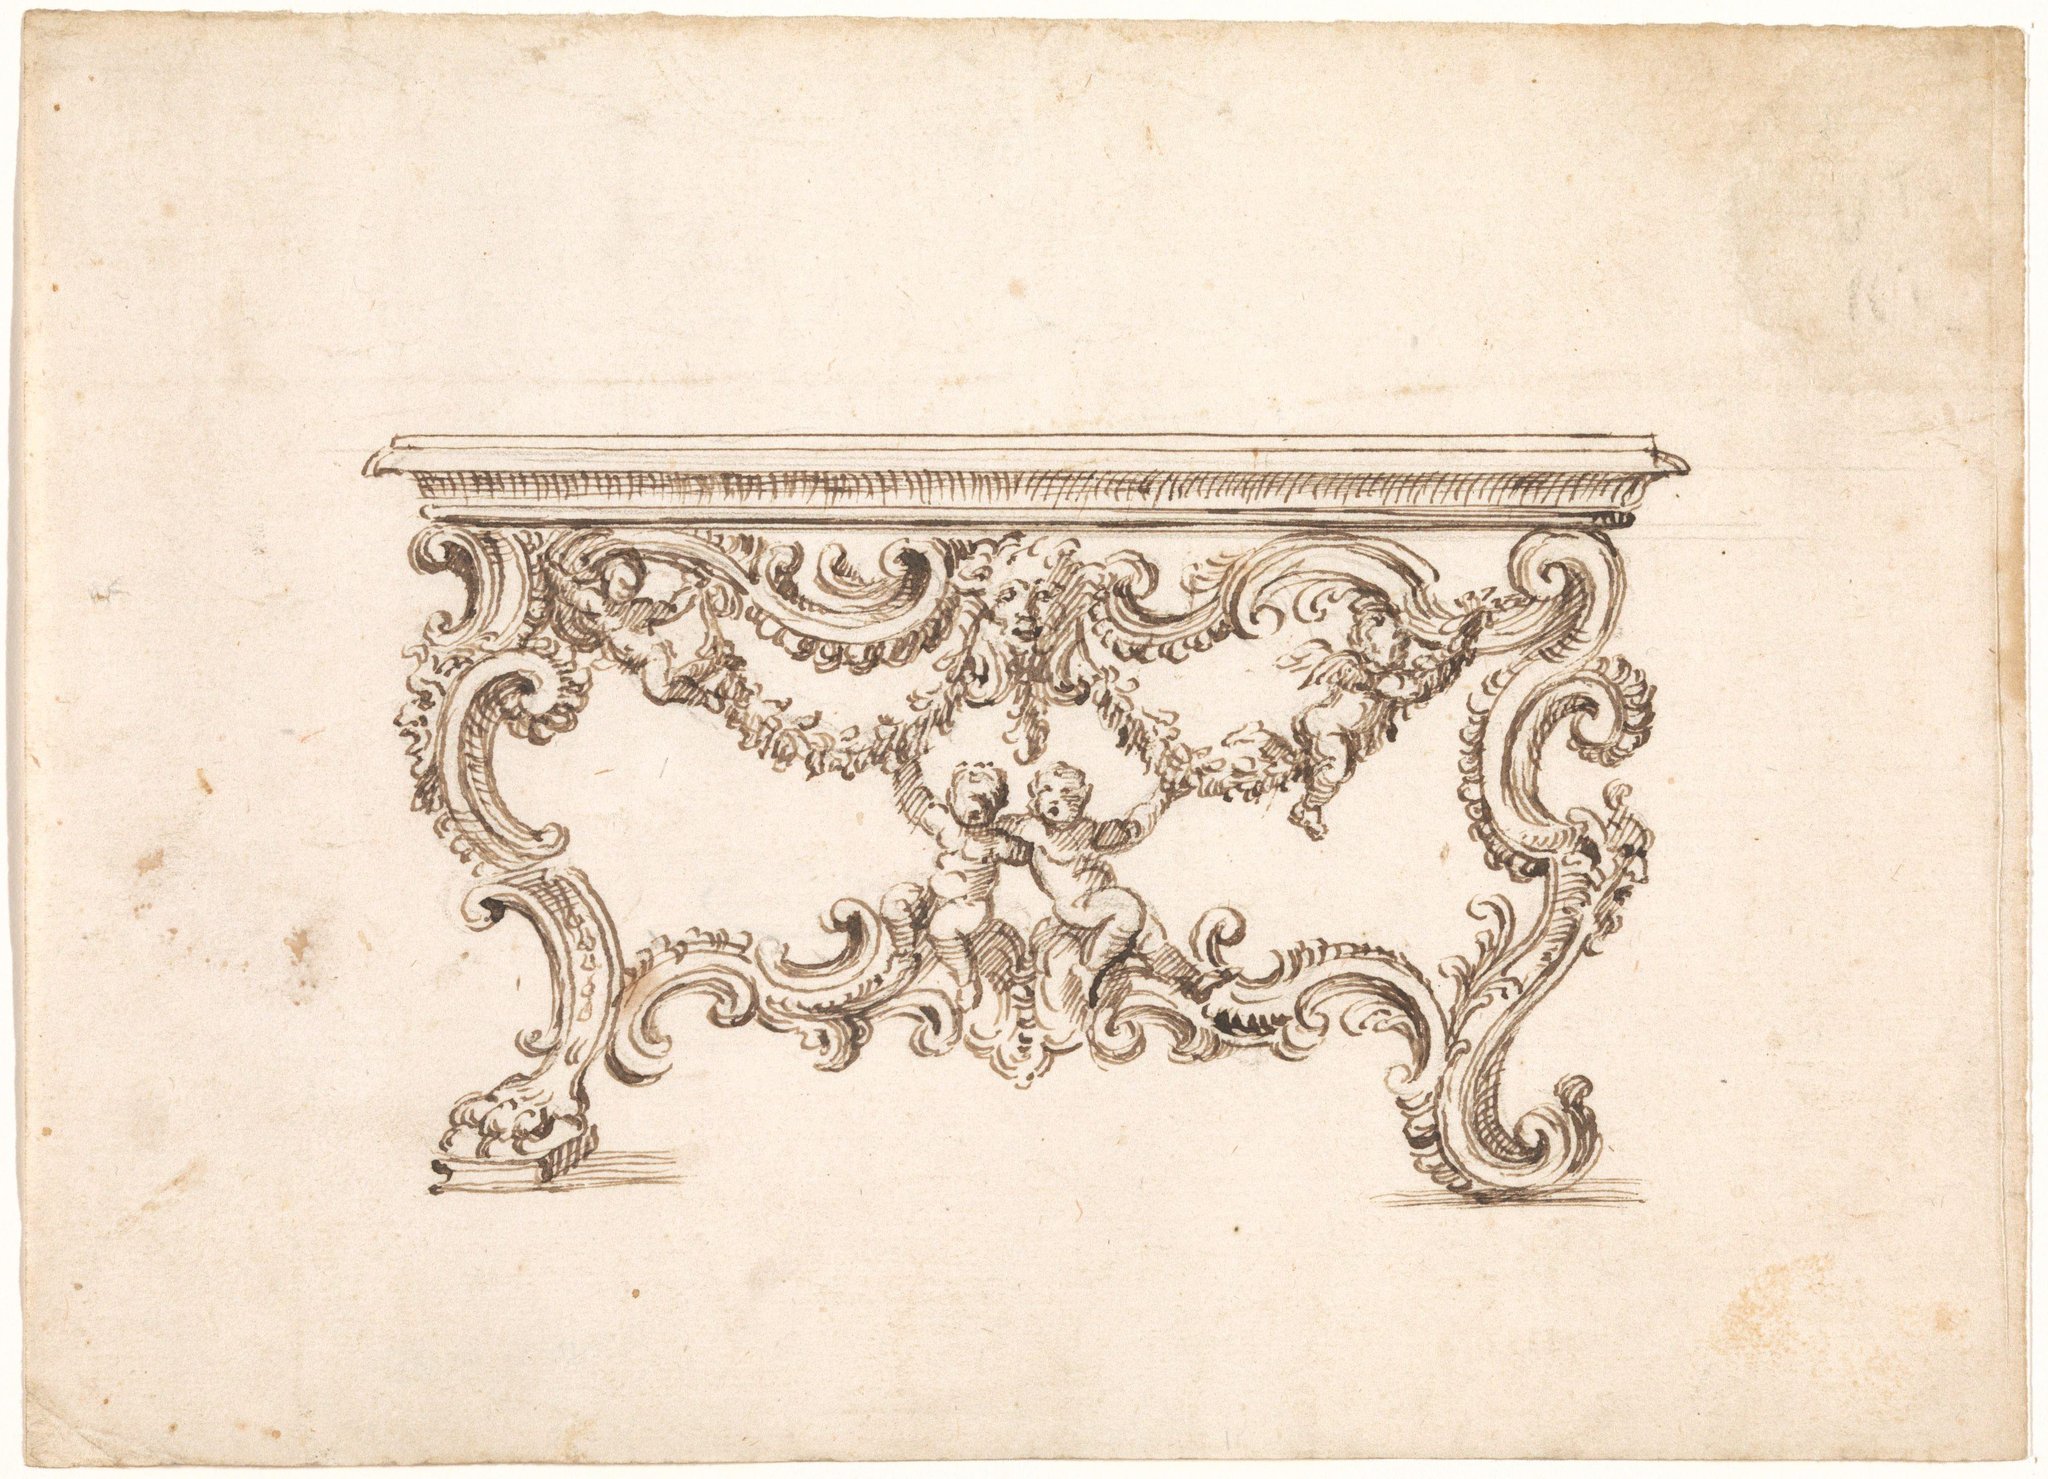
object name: drawing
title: Ontwerp voor wandtafel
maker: Anonymous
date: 1700-1725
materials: graphite, paper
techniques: pen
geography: rome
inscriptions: watermark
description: Ontwerp voor een gebeeldhouwde wandtafel, met twee alternatieve helften.